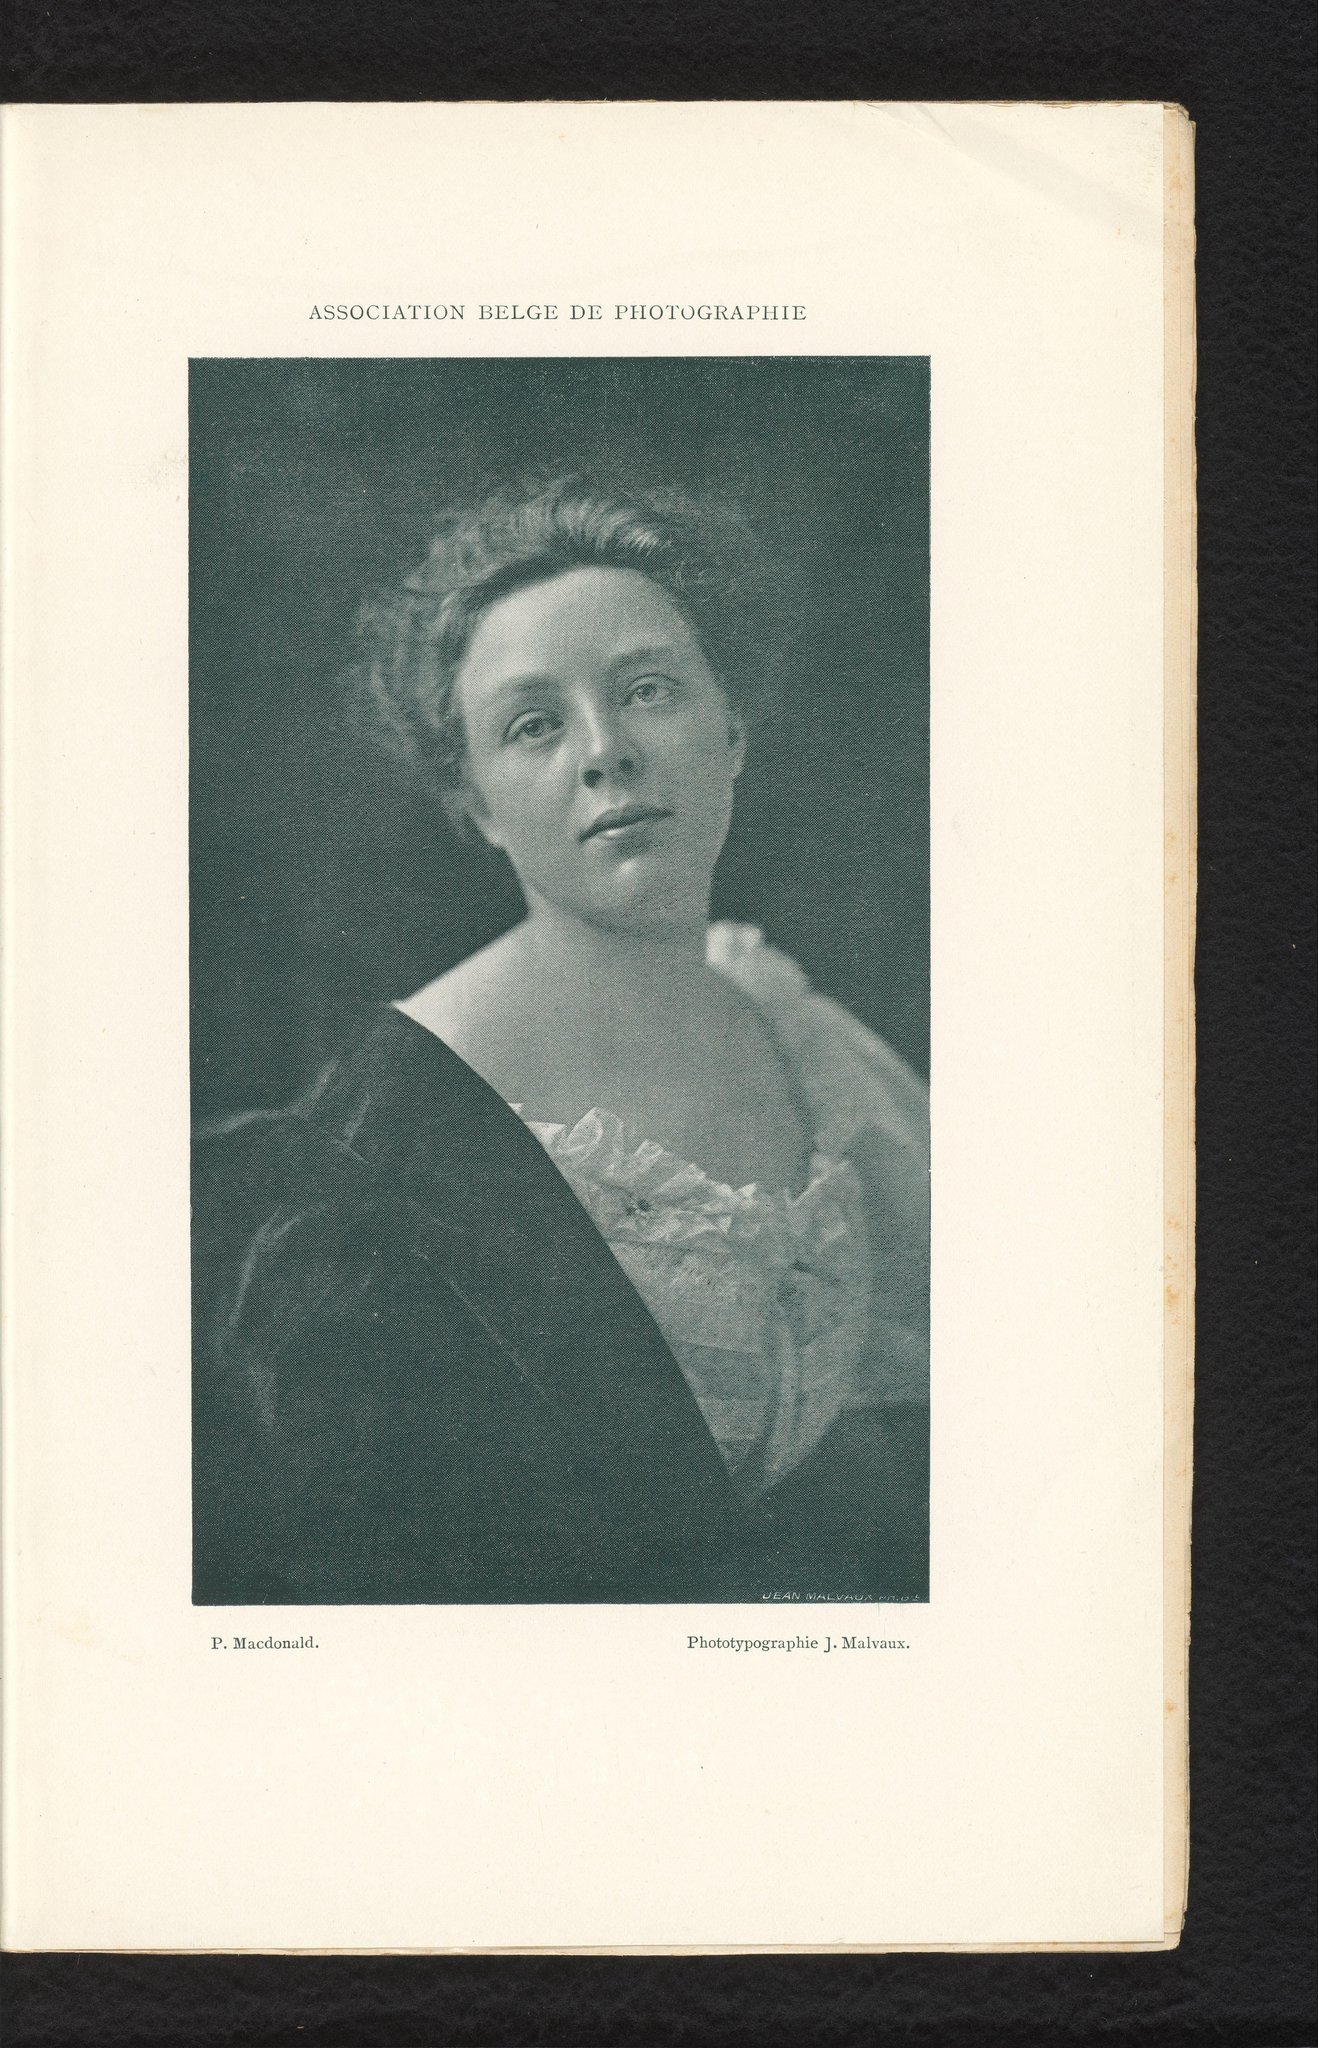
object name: photomechanical print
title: Portret van een onbekende vrouw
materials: paper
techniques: autotype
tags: historical persons not known by name - bb - woman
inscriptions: inscription: ‘ASSOCIATION BELGE DE PHOTOGRAPHIE’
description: Prent op derde ongenummerde pagina na pagina XVI.